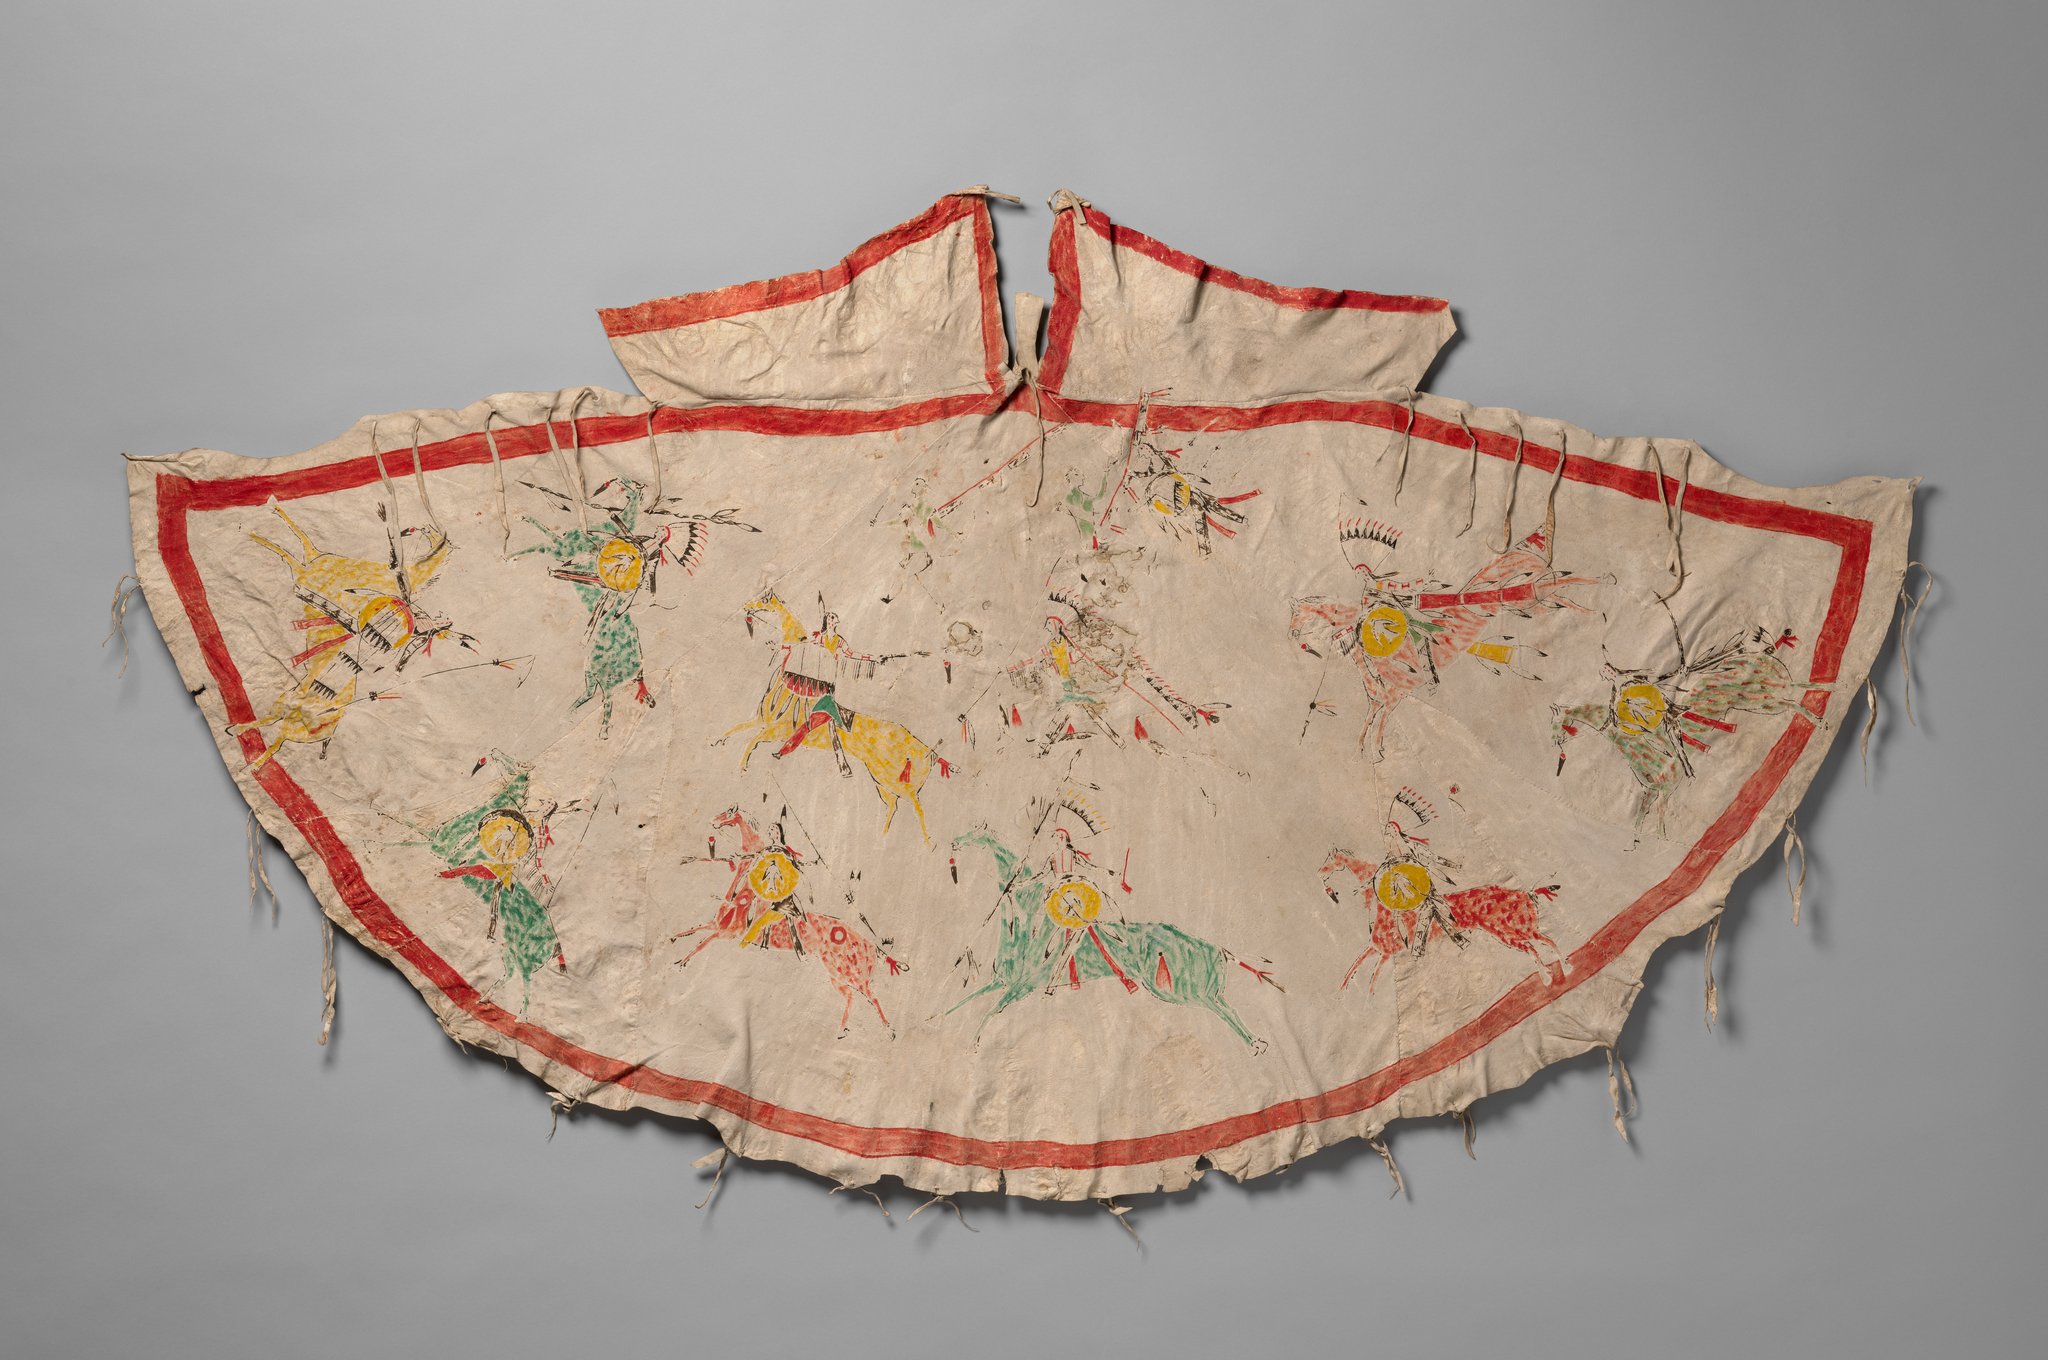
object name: model tipi cover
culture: lakota or sicangu oyate or teton sioux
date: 1885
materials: leather, pigment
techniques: tanning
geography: united states